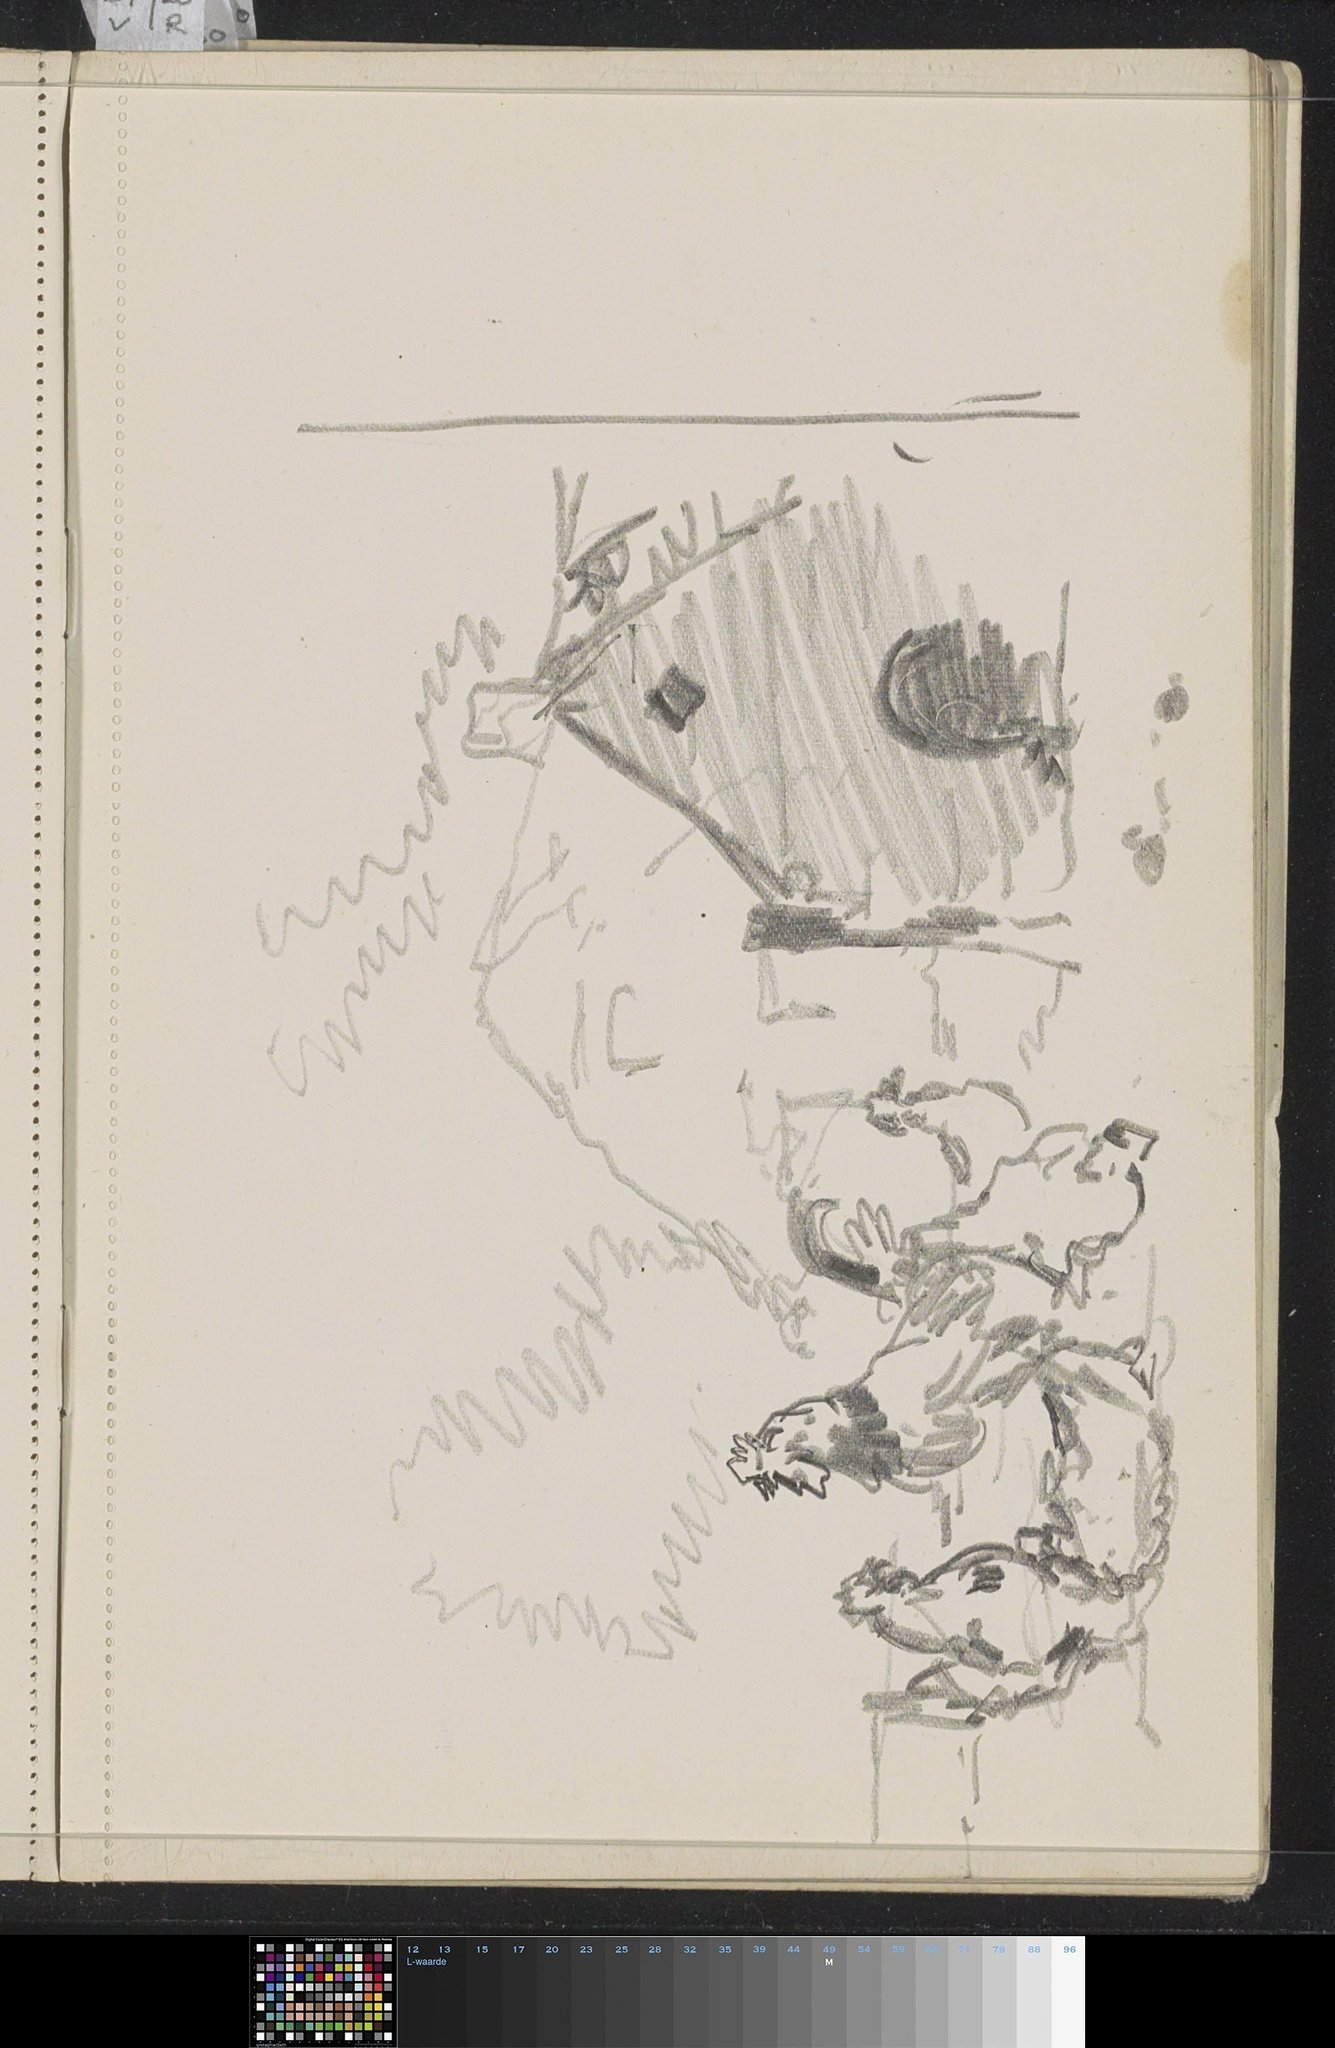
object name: sketchbook leaf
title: Scharrelende kippen voor een boerderij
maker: cornelis vreedenburgh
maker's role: draughtsman, print maker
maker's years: 1880-1946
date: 1890-1946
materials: paper, pencil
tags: fowl (cock, hen, chicken, etc.), farm (building)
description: Blad 22 recto uit een schetsboek met 61 bladen.